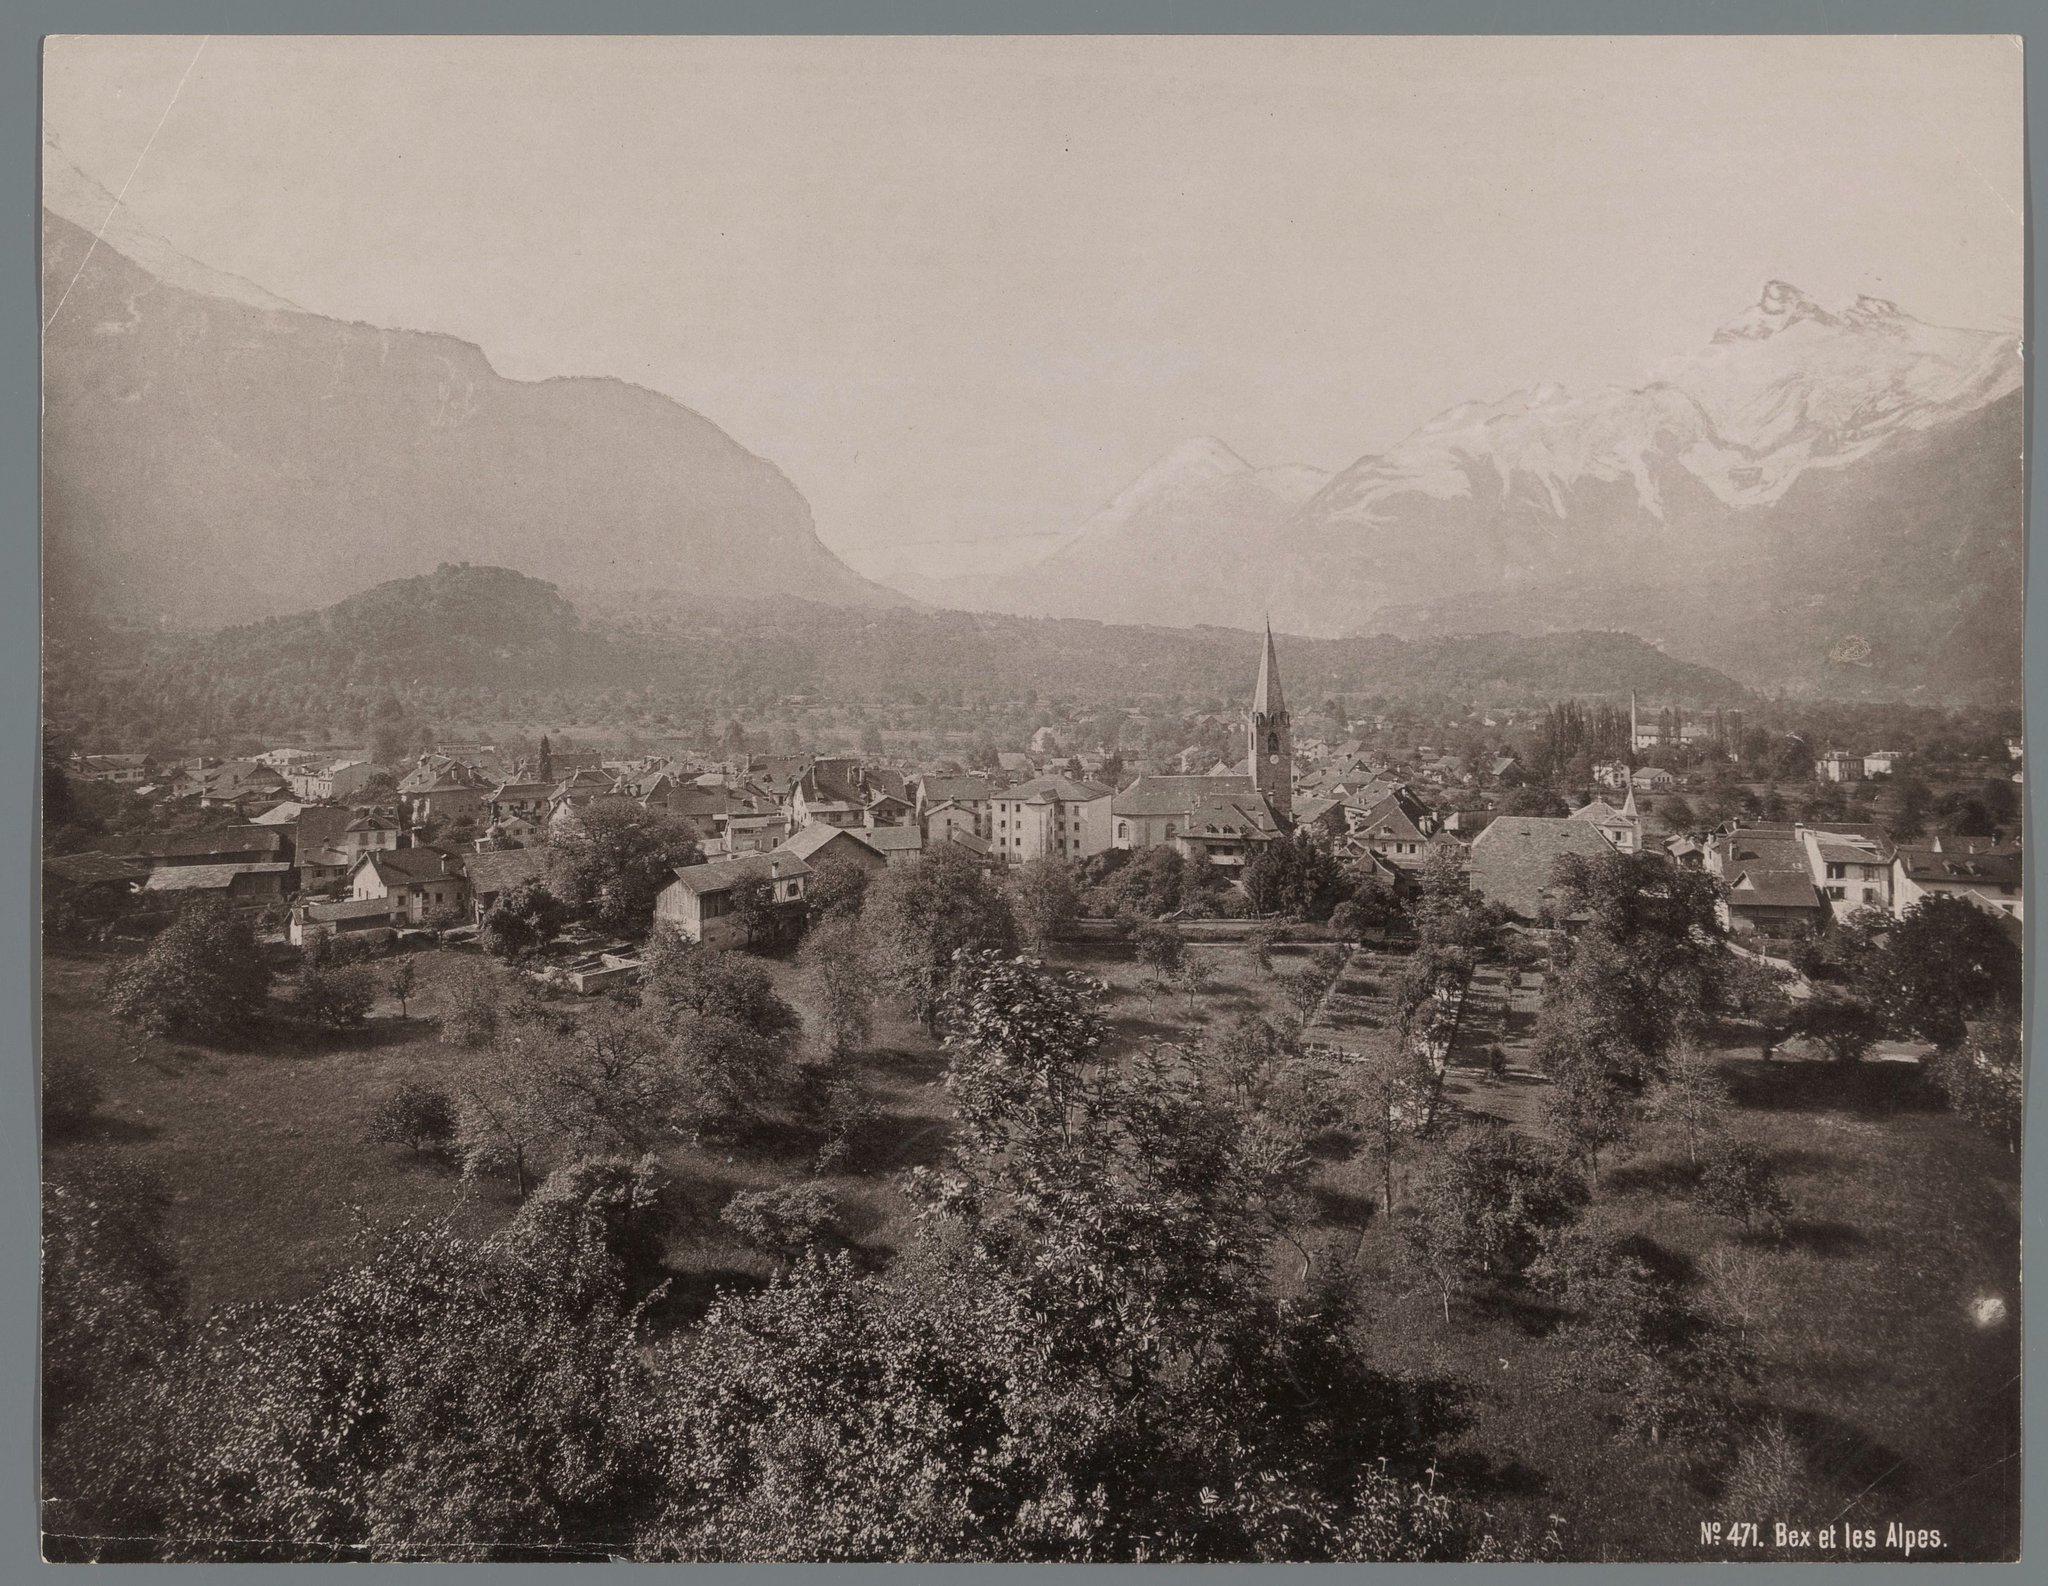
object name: photomechanical print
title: Bex et les Alpes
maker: Anonymous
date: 1870-1930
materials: paper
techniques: photograph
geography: bex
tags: city-view in general; 'veduta', mountains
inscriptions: inscription: ‘[...] Fig [...] verlag/ Weggis (Luzern)’, number: ‘No 471.’